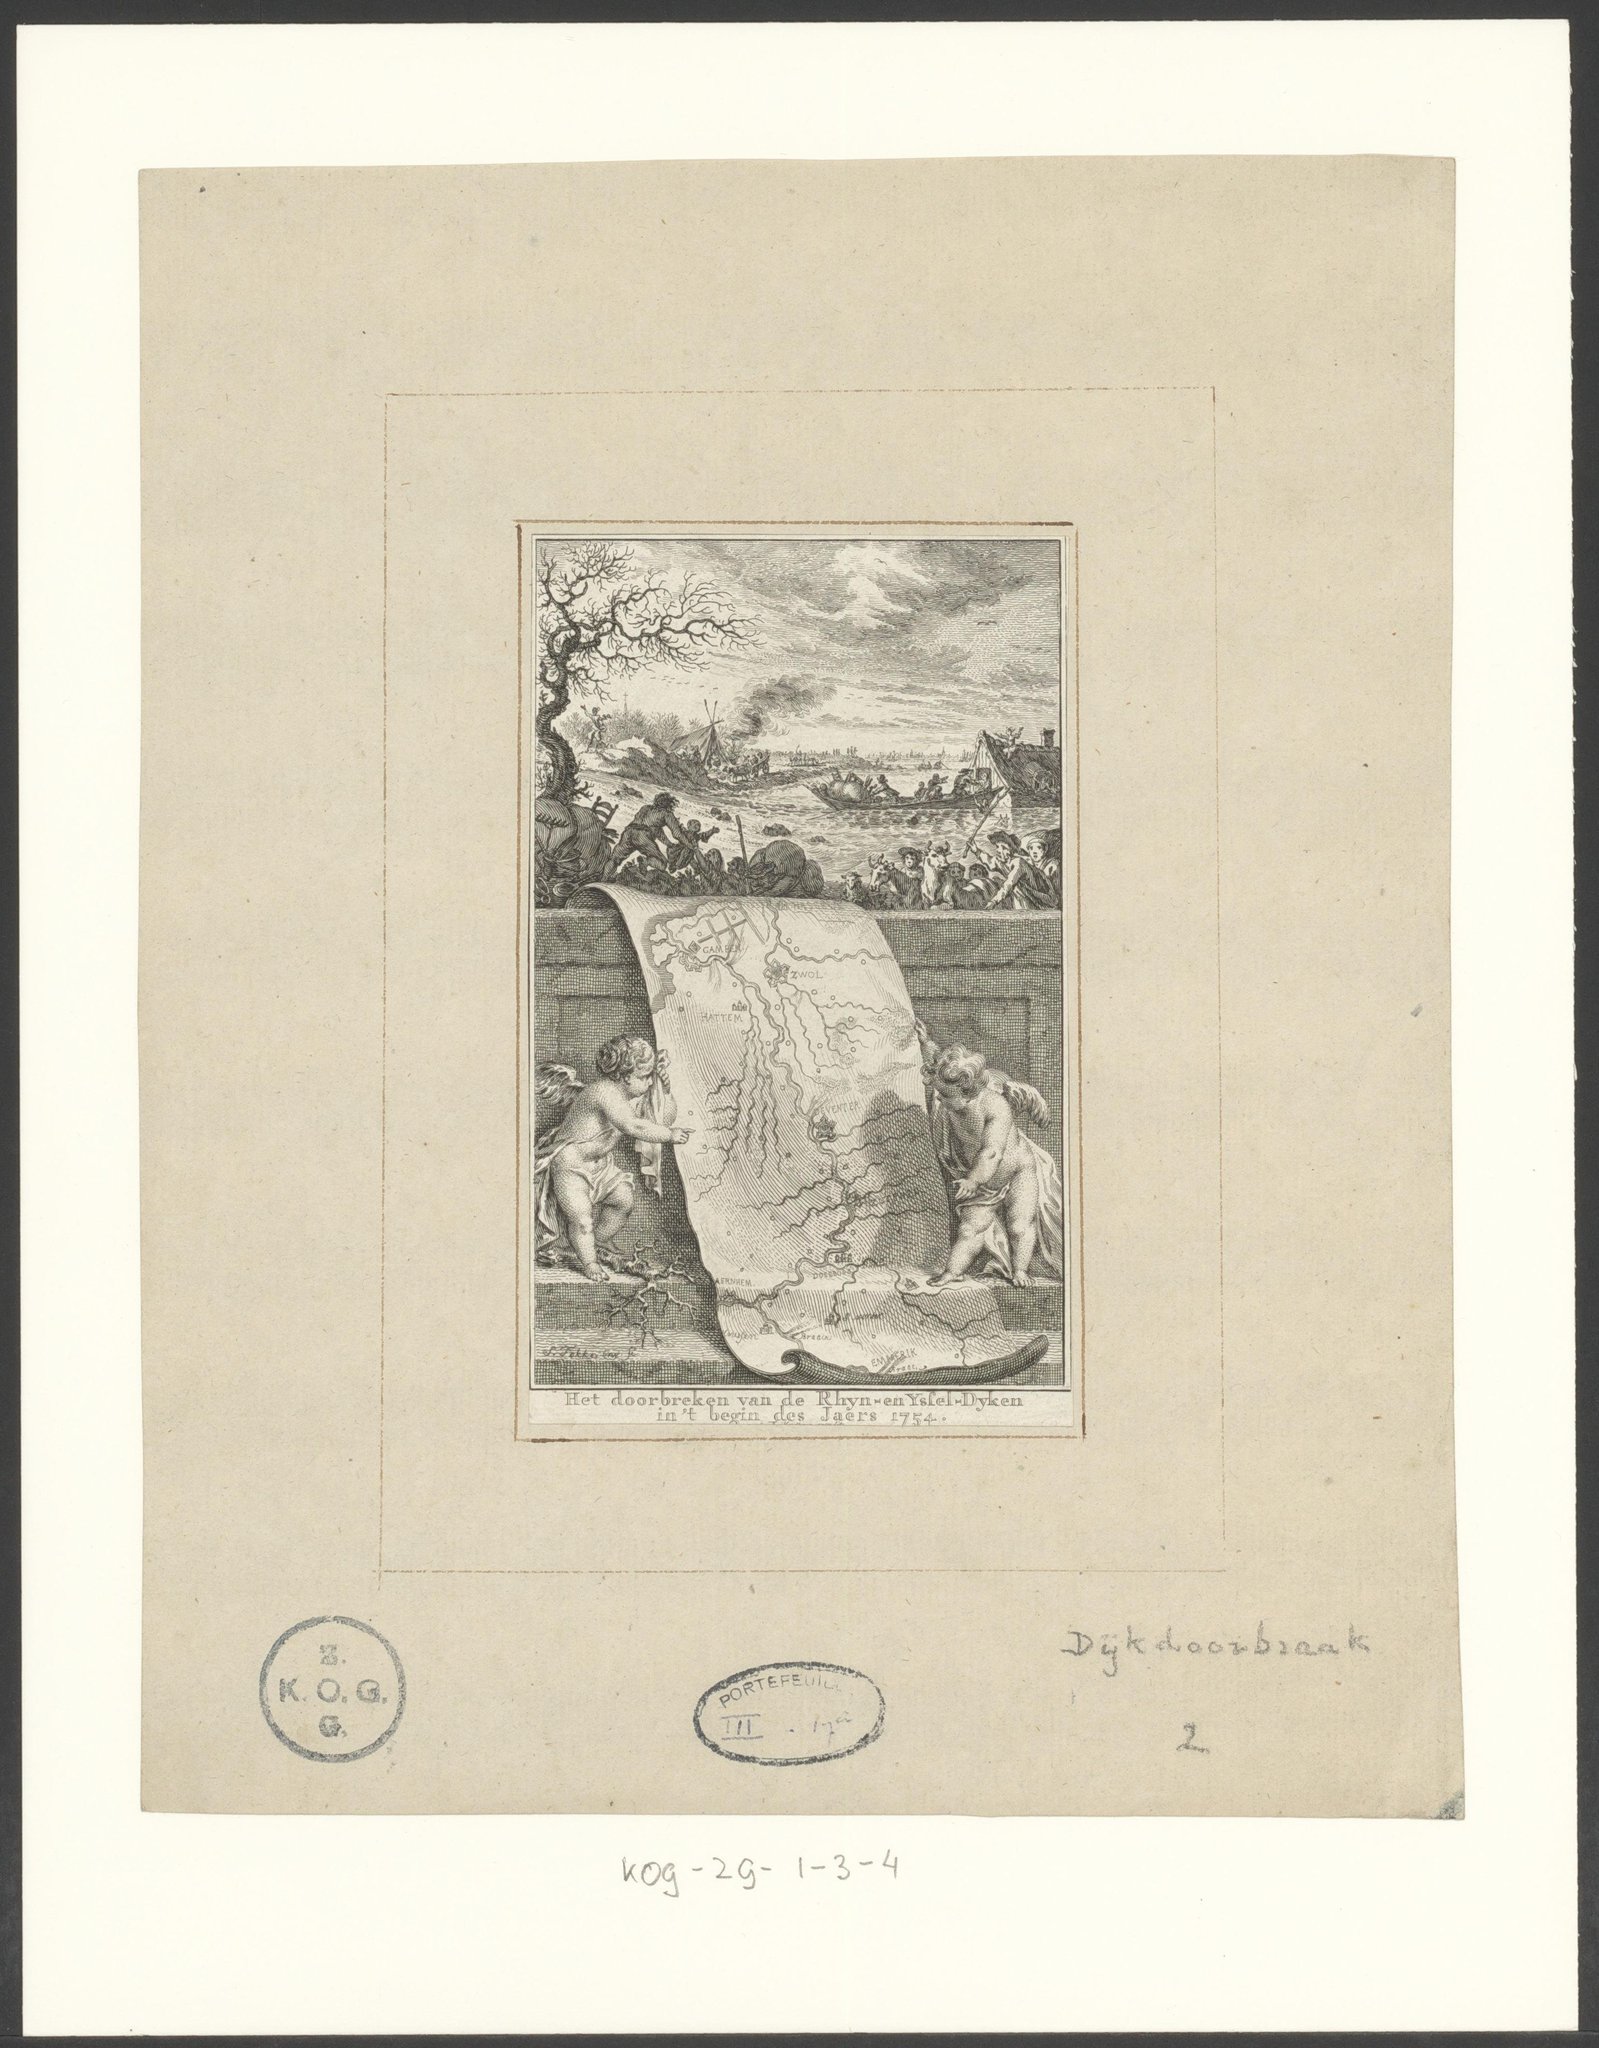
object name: print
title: Het doorbreken van de Rhyn- en Yssel-Dyken in 't begin des Jaers 1754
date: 1754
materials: paper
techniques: engraving, etching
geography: amsterdam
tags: dike-break, flight, running away; pursuing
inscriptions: collector's mark: Lugt 1641, stamp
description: Watersnood na het doorbreken van de rivierdijken langs de Rijn en de IJssel, januari 1754. Onderaan twee putti met een kaart van het rivierengebied tussen Kampen en Emmerich, bovenaan ontvluchten bewoners het overstroomde land met huisraad en vee. Onderwerpsrubrieken binnen de Atlas Zeden en Gewoonten: Regeering, Dijkdoorbraken en waternoden.